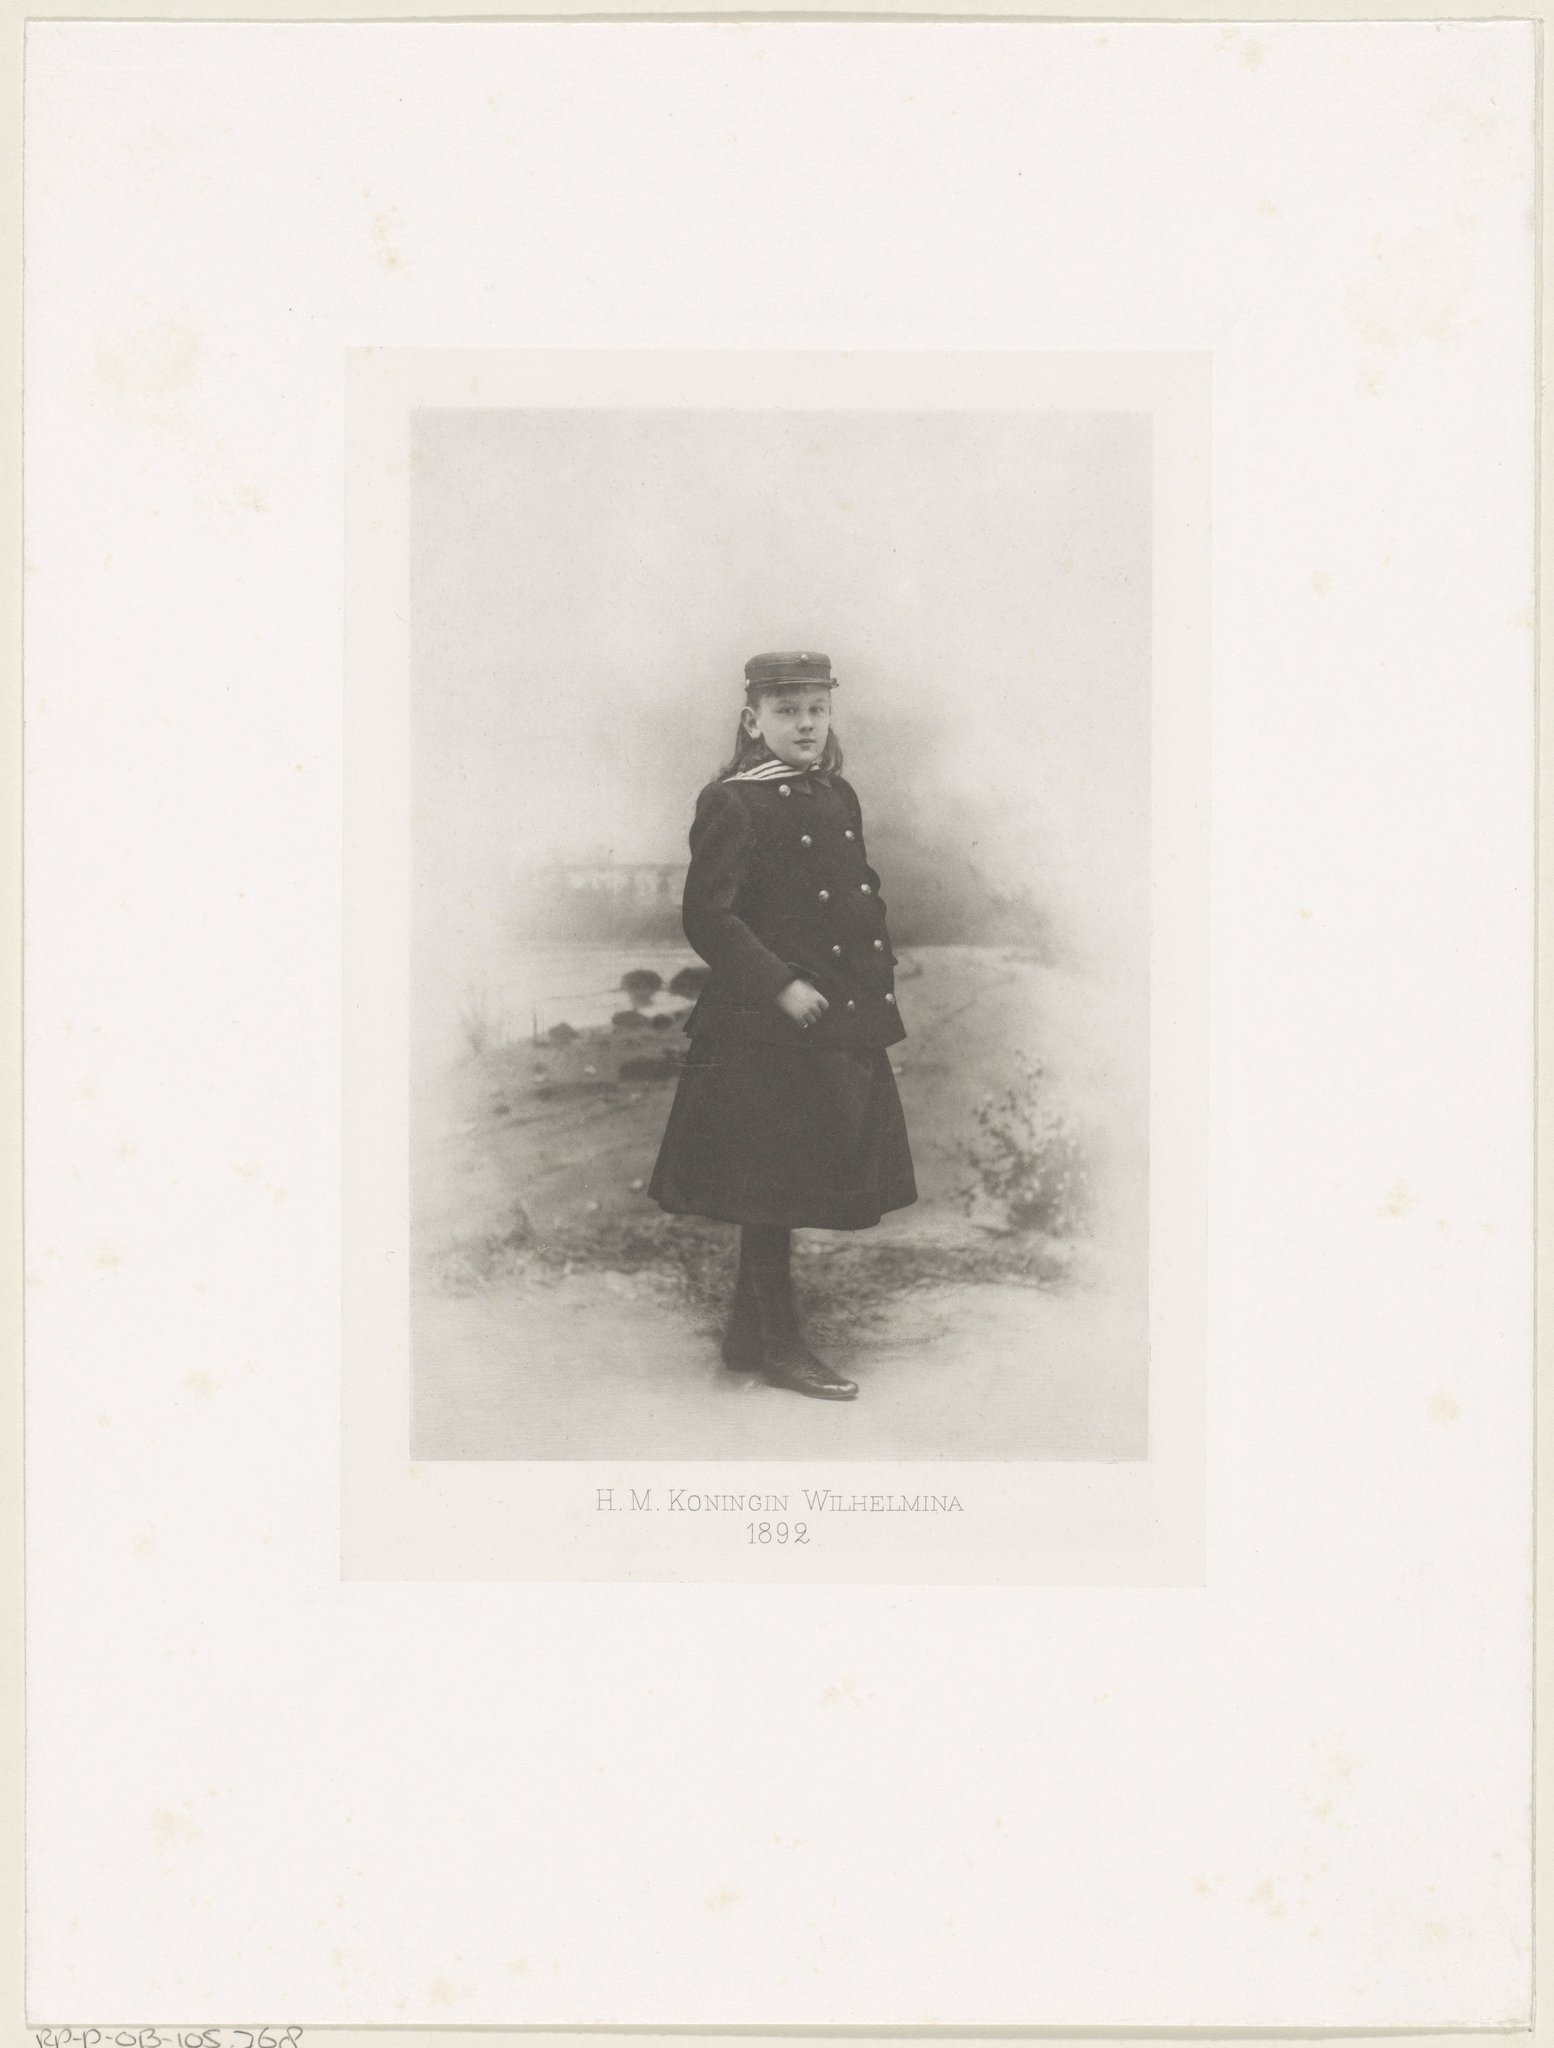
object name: photomechanical print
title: Portret van Wilhelmina, koningin der Nederlanden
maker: Anonymous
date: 1892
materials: paper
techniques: photoaquatint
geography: berlin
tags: the hague, print maker, wilhelmina of the netherlands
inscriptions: date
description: De hier vermelde titel verwijst naar de hoogst verkregen titel van de geportretteerde, niet per se naar de titel die de geportretteerde op deze voorstelling draagt.